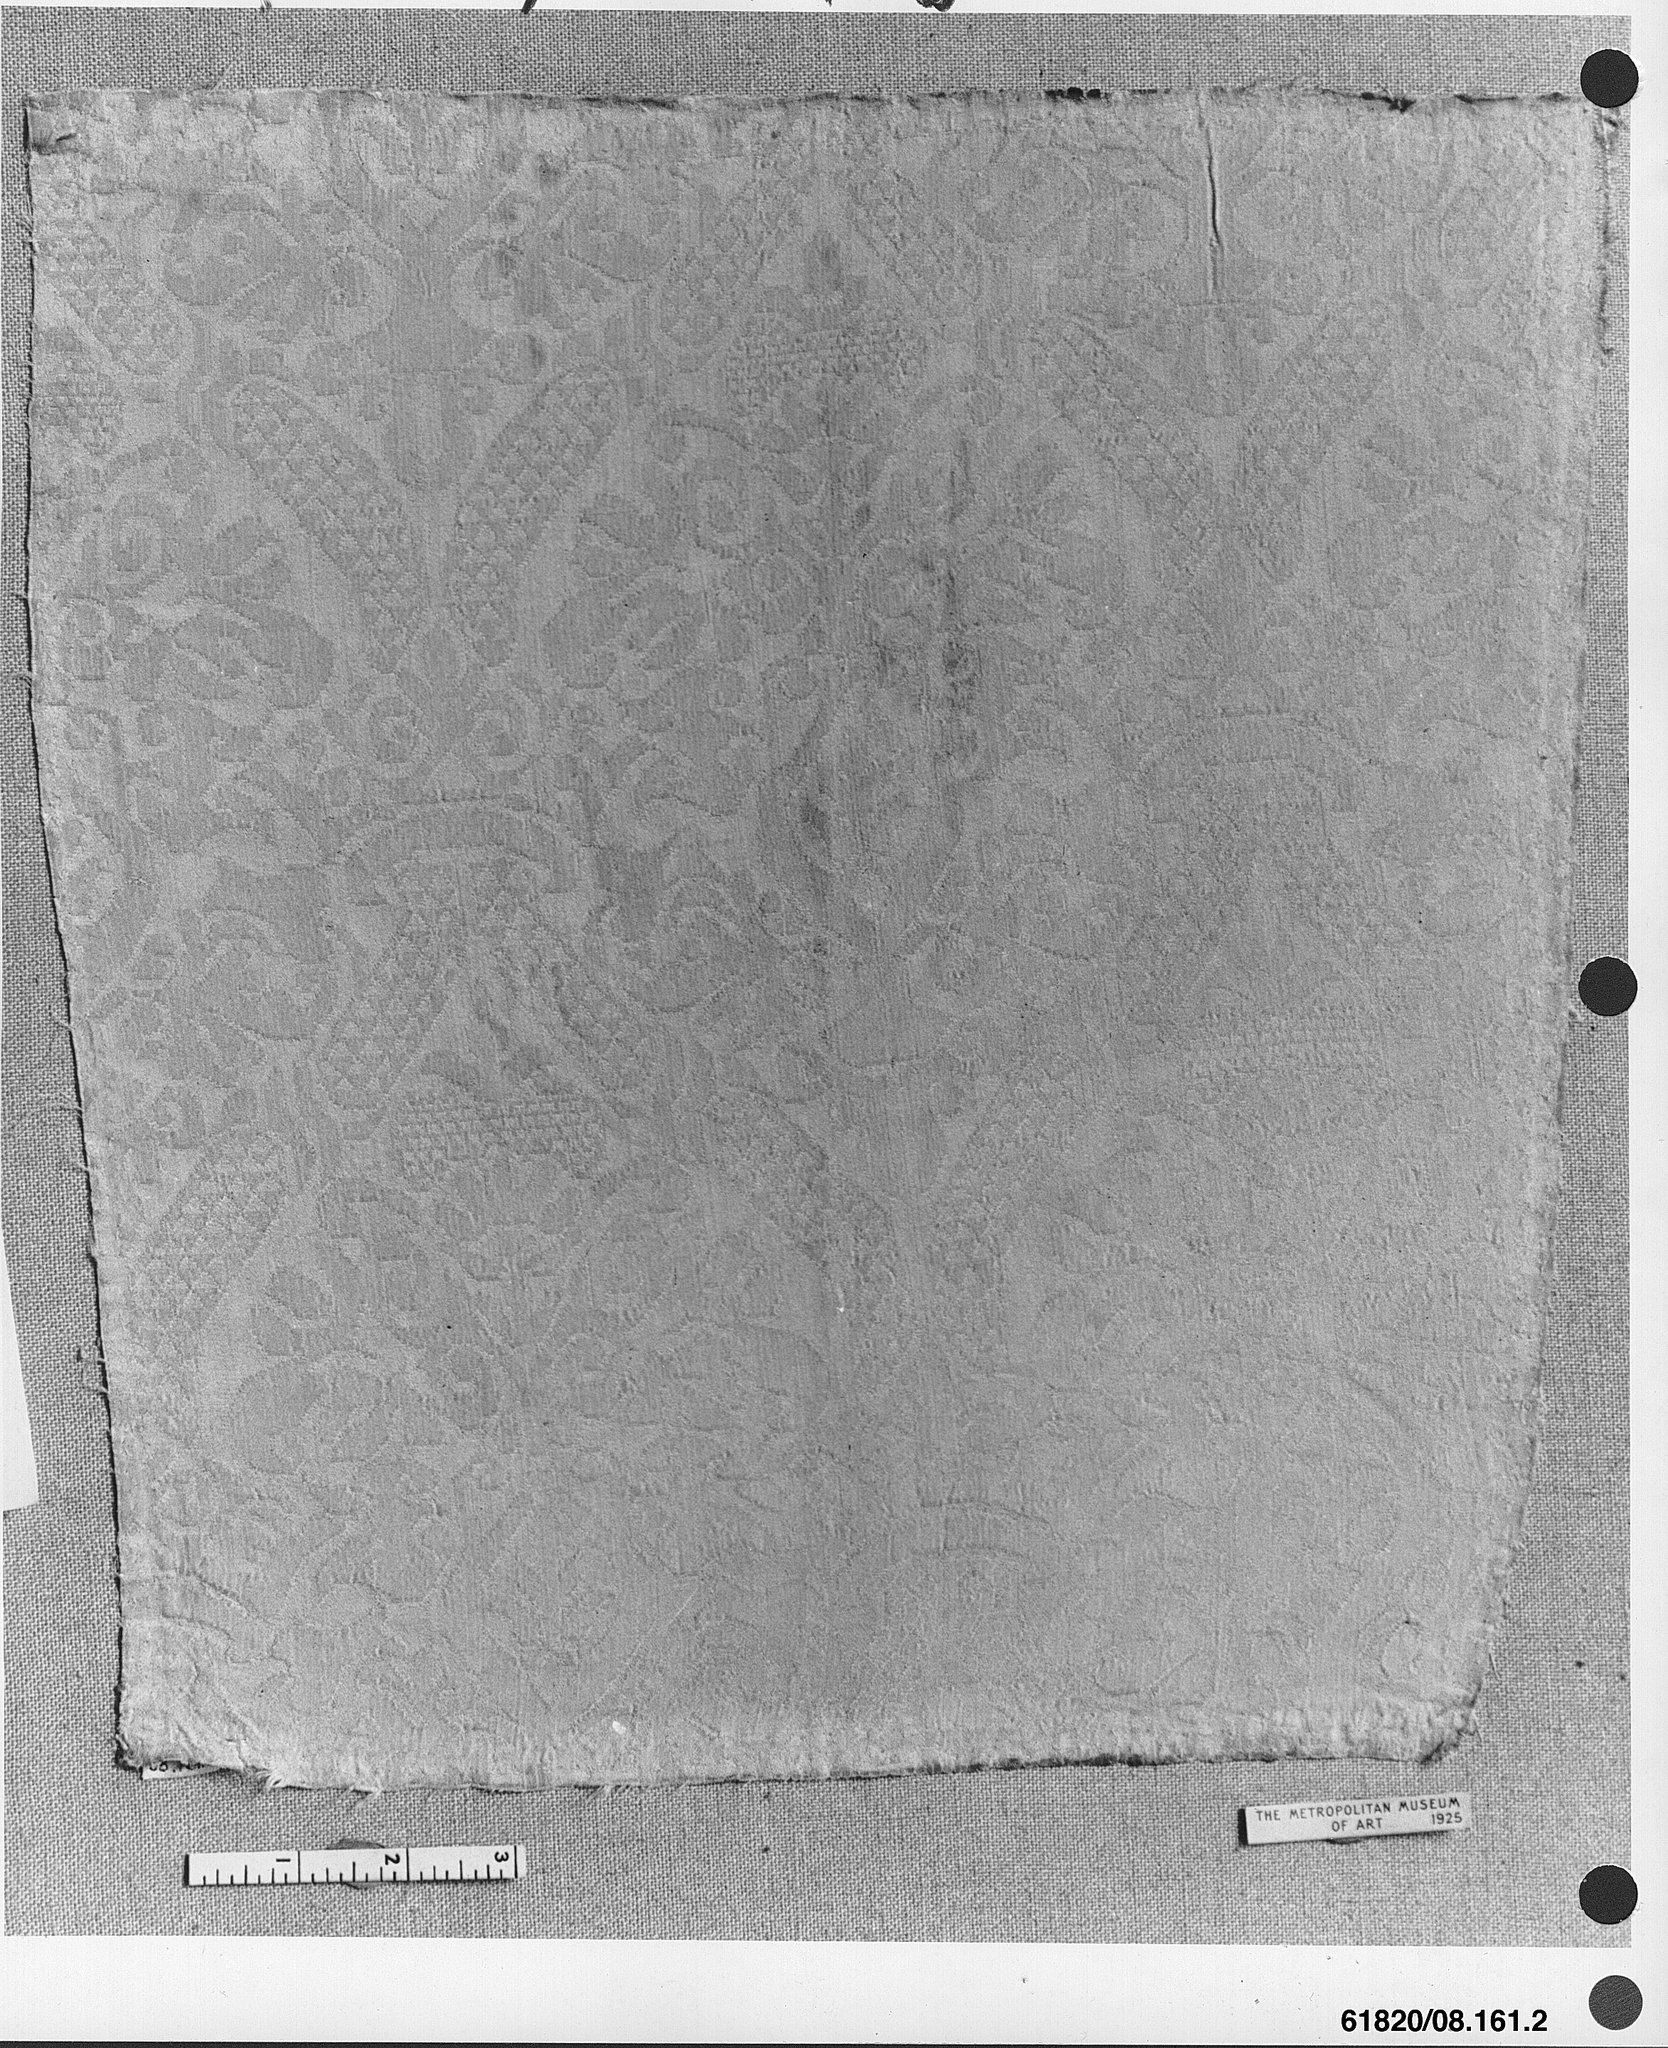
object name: piece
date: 1501-1600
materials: silk